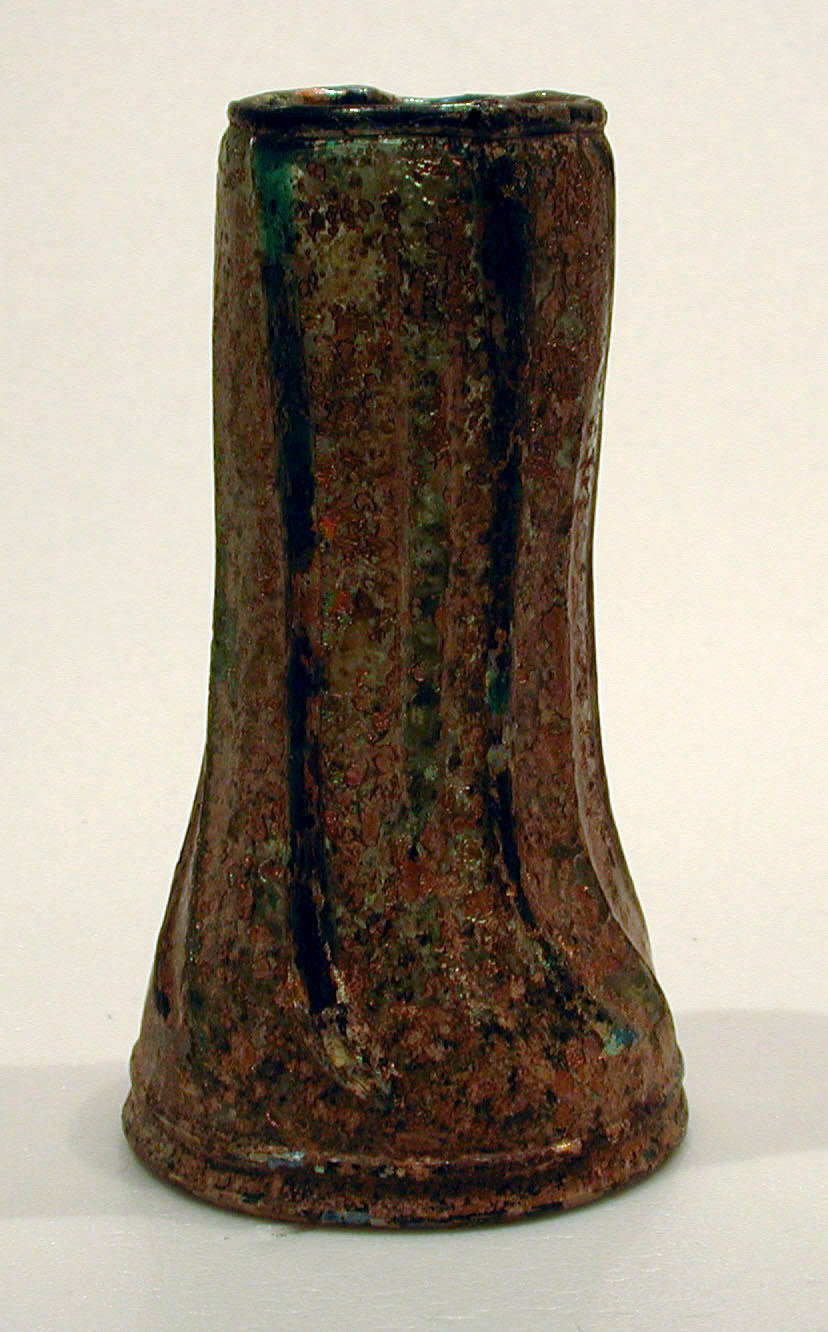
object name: beaker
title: Beaker with Vertical Trails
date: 1201-1400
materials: glass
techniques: glassblowing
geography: syria